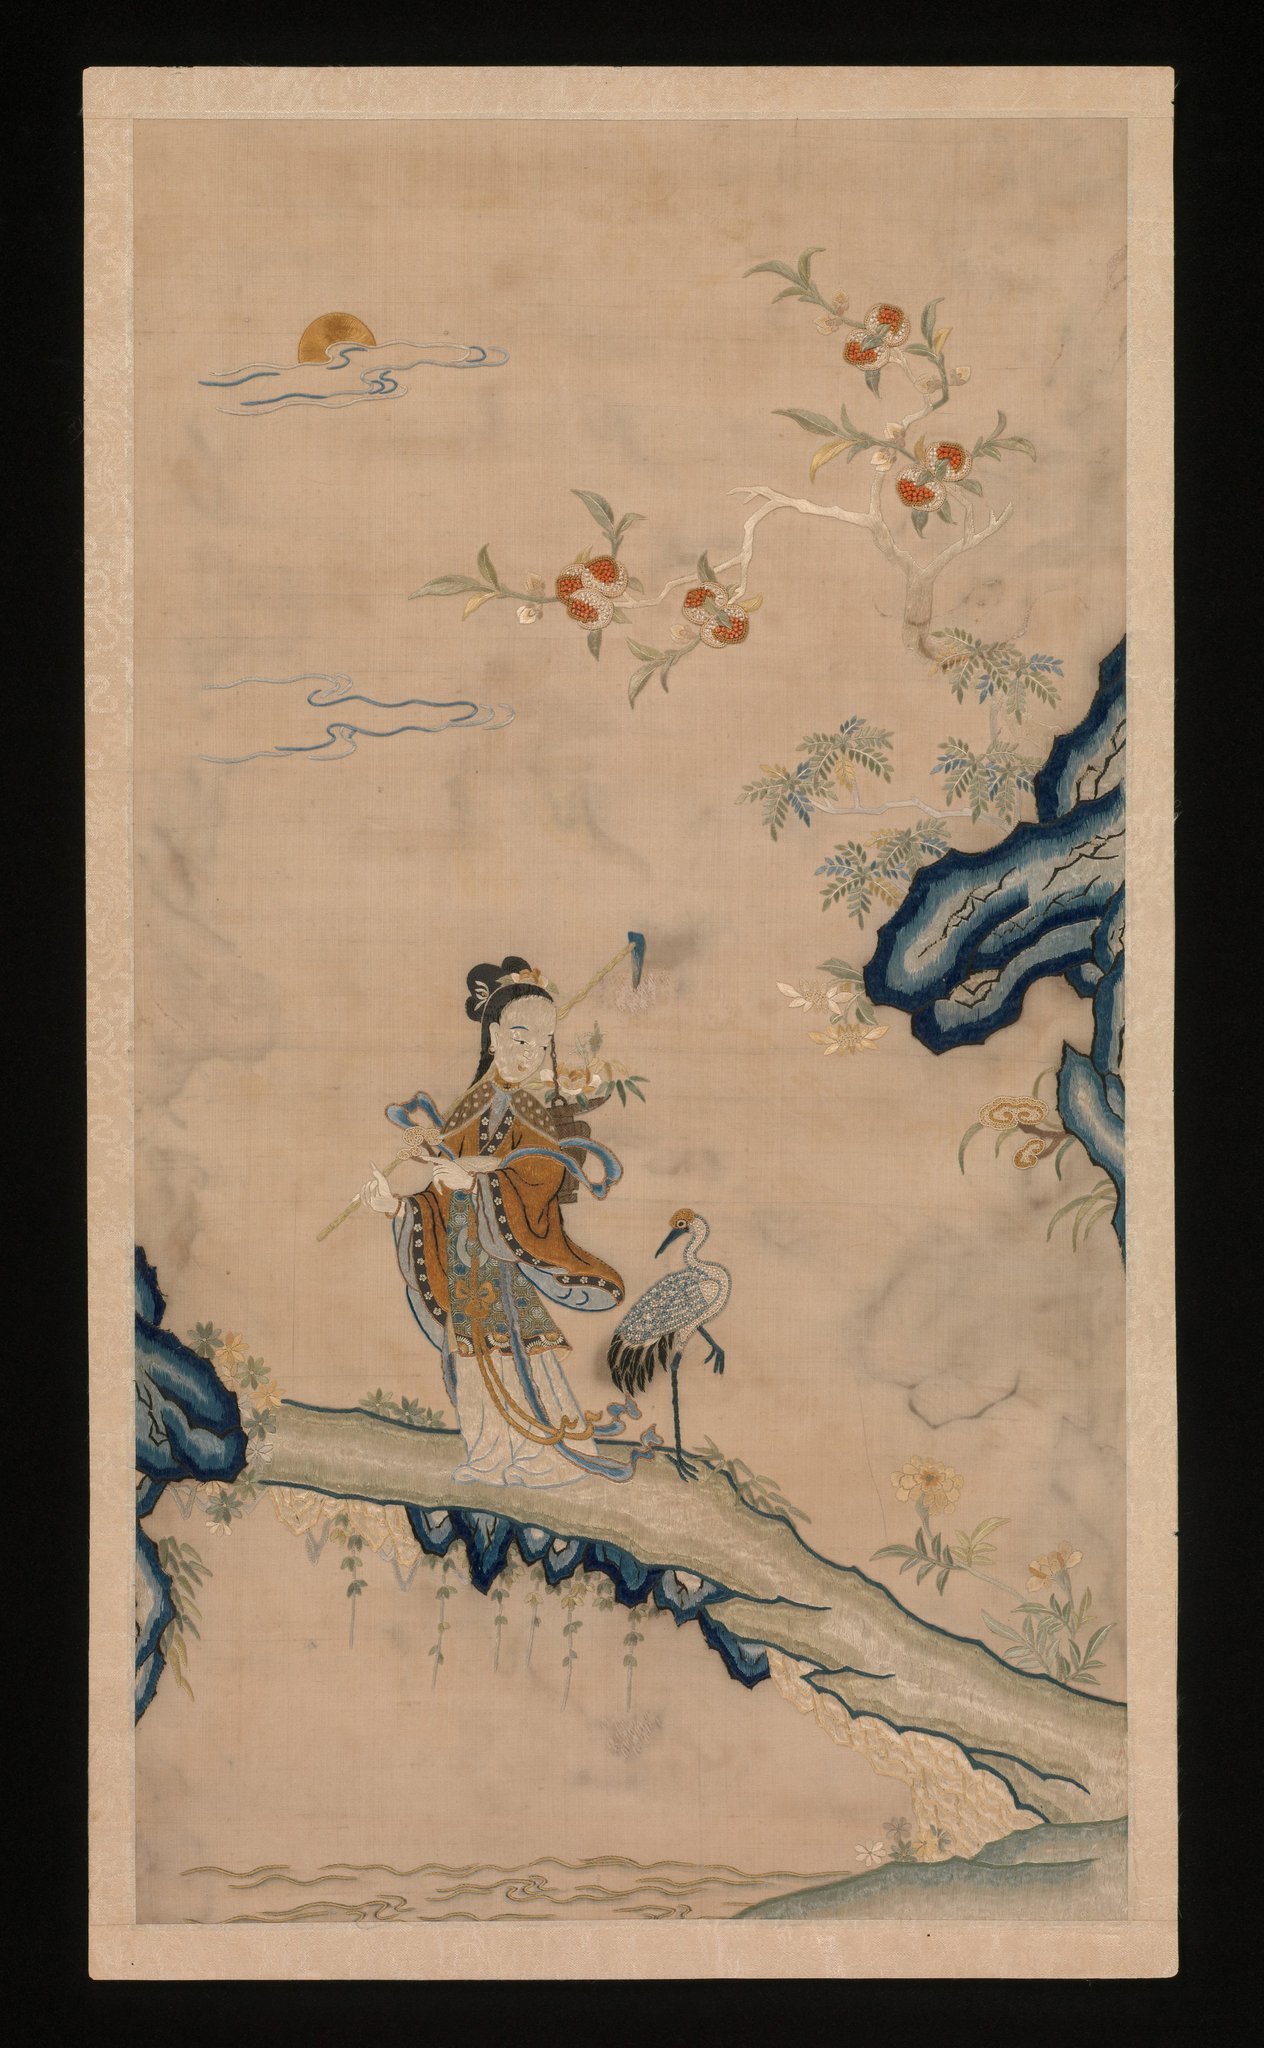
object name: panel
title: Fairy and Crane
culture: chinese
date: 1701-1800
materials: coral, pearl, silk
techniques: embroidery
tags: bridges,fruit,fairies,trees